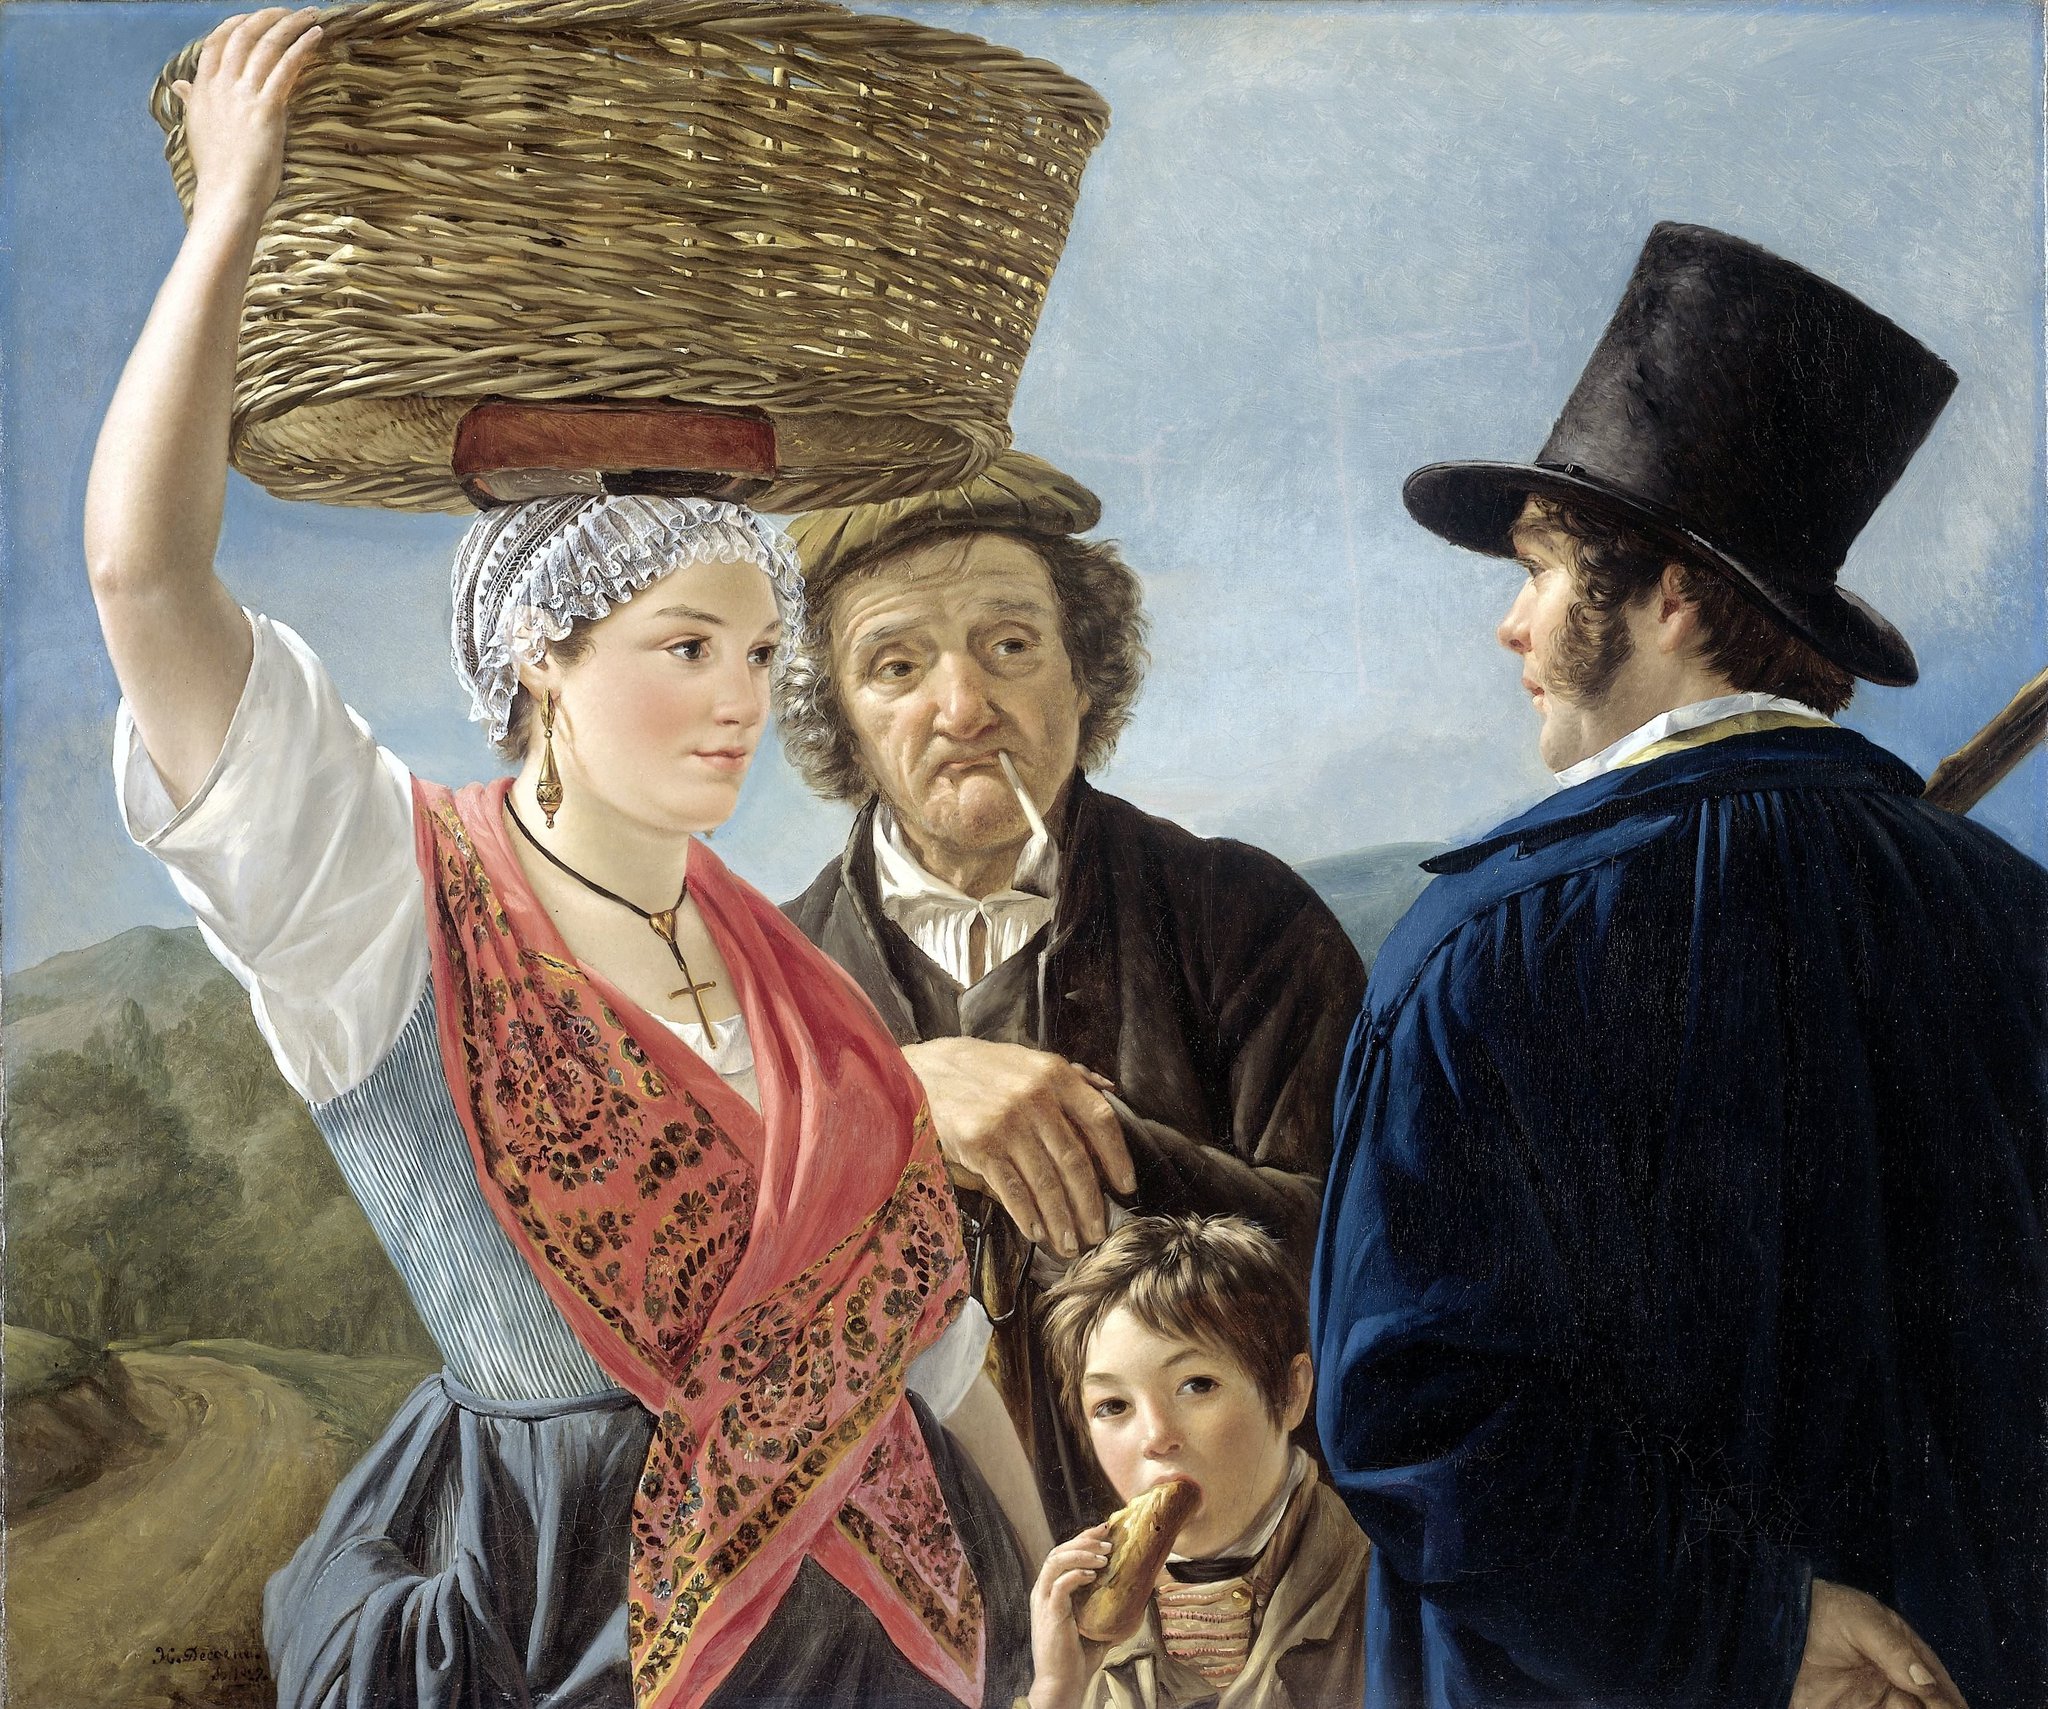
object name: painting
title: Market Gossip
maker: jean henri de coene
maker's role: painter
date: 1827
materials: canvas, oil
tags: going to the market, carrying something on the head or on the shoulders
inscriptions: signature and date: ‘H. Decoene ft 1827’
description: Marktnieuws. Een jonge vrouw met een mand op haar hoofd in gesprek met een jonge man met hoge hoed. Een oude man met pijp luistert toe, ook een jongen die een stuk koek eet.